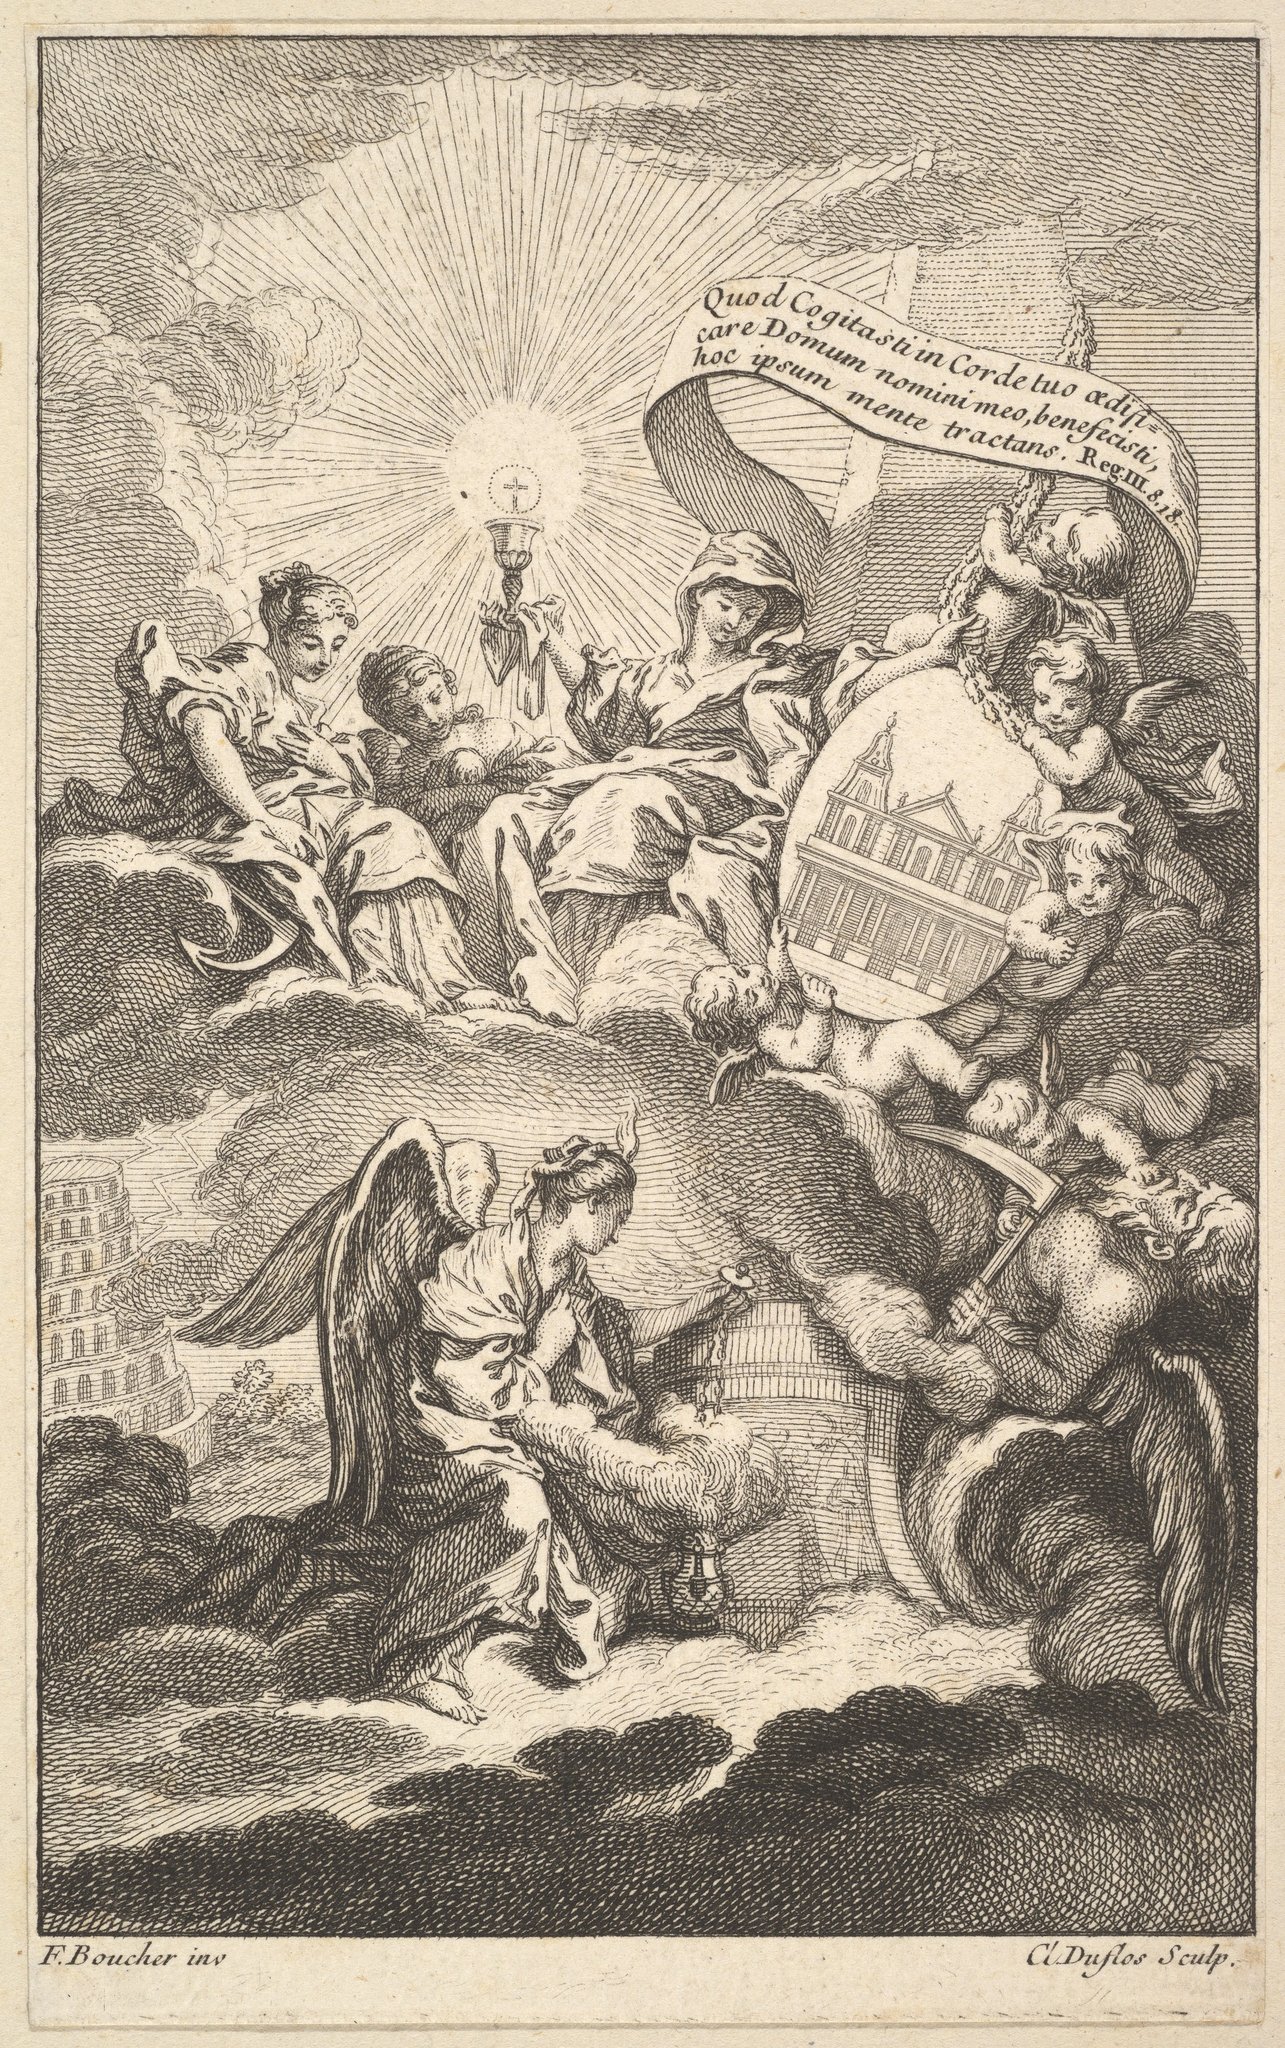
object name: print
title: Frontispiece, from The Building of St. Sulpice by Alexis Piron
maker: claude augustin duflos le jeune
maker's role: artist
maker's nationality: french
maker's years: 1700-1786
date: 1744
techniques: engraving, etching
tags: buildings,angels,cross